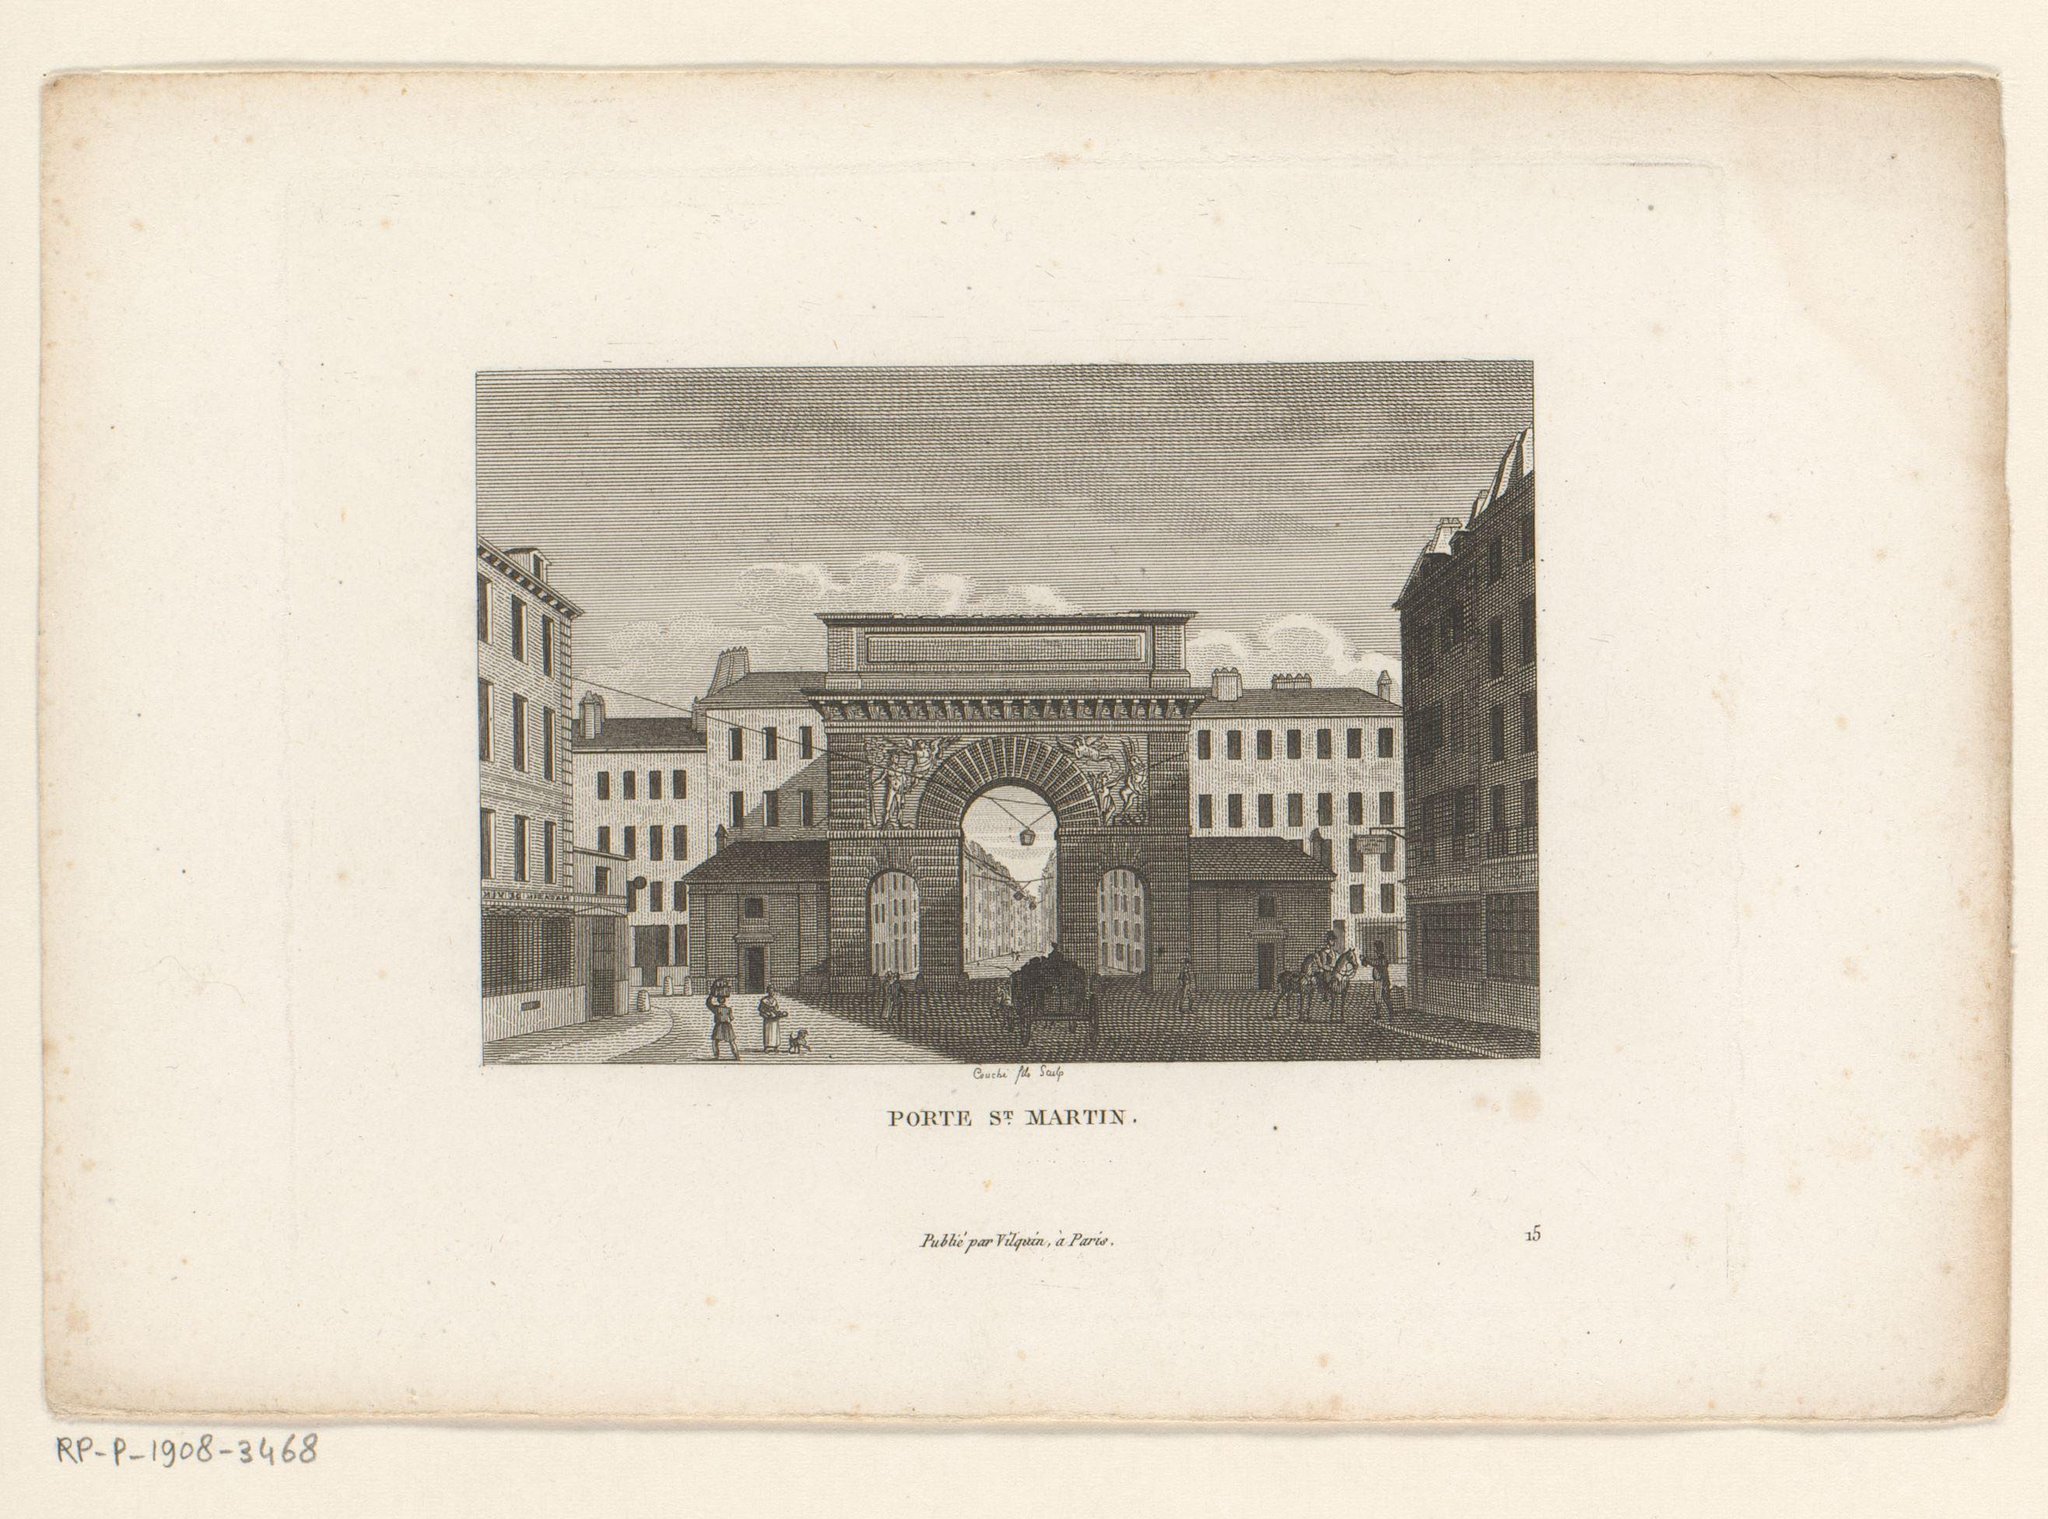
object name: print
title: Porte St. Martin.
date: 1818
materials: paper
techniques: etching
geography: paris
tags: city-view in general; 'veduta', triumphal arch, paris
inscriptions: collector's mark: Lugt 2228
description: Maakt deel uit van een serie met 60 platen van monumenten, kathedralen en paleizen in Parijs.